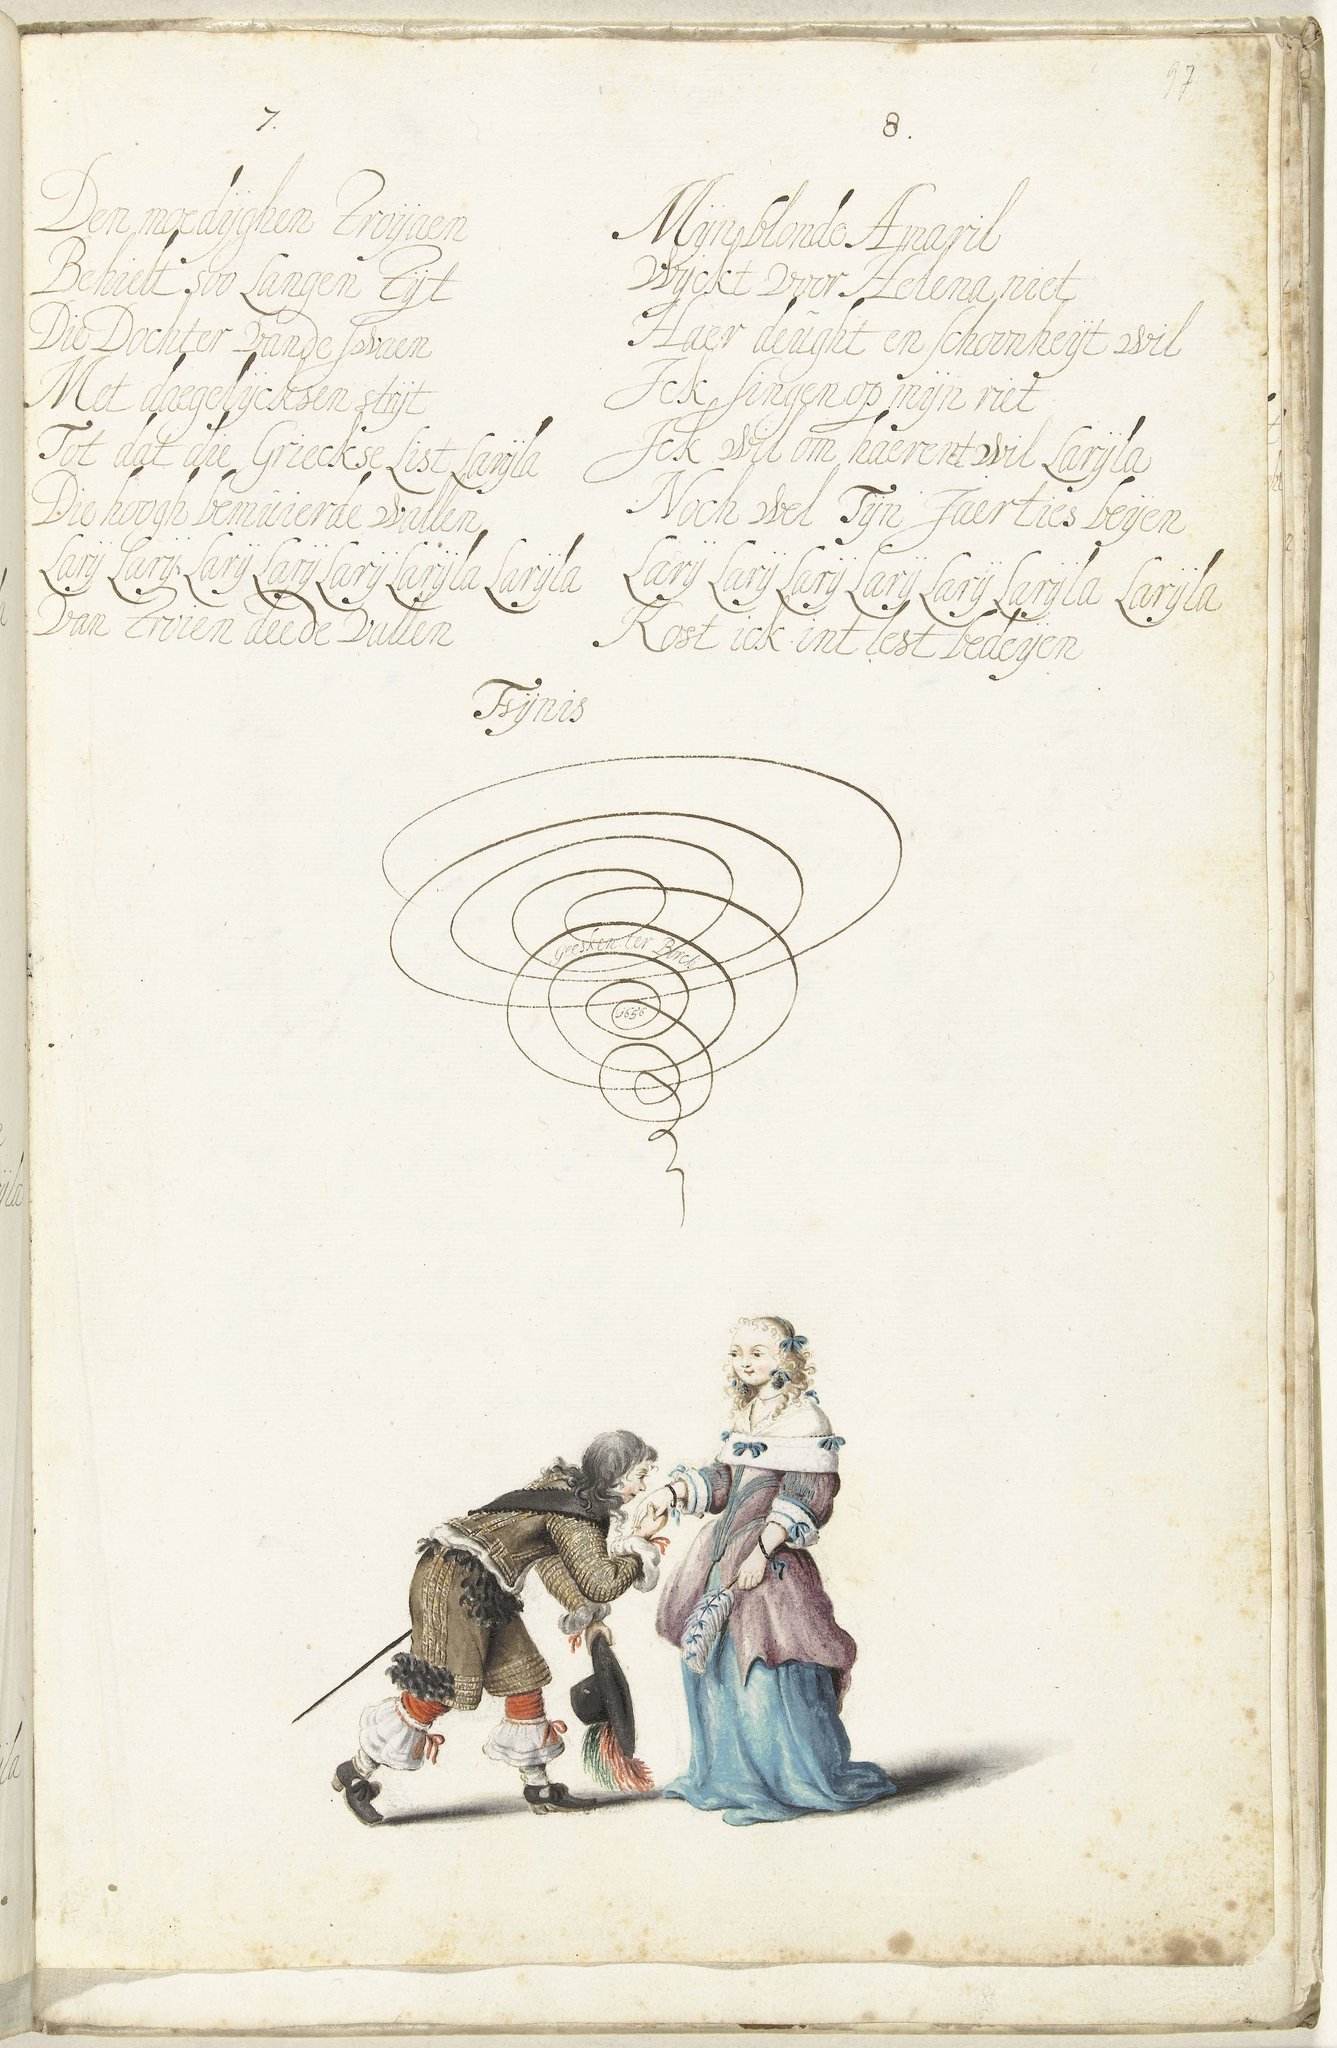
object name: watercolor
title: Heer die de hand van een dame kust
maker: gesina ter borch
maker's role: draughtsman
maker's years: 1633-1690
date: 1656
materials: ink, paper, watercolor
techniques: brush, calligraphy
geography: zwolle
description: Het lied werd gepubliceerd in het 'Nieu dubbelt Haerlems lietboeck' van 1643 (Deel I, p. 50) met de melodievermelding 'Je ne peu Amaril, retourne'.